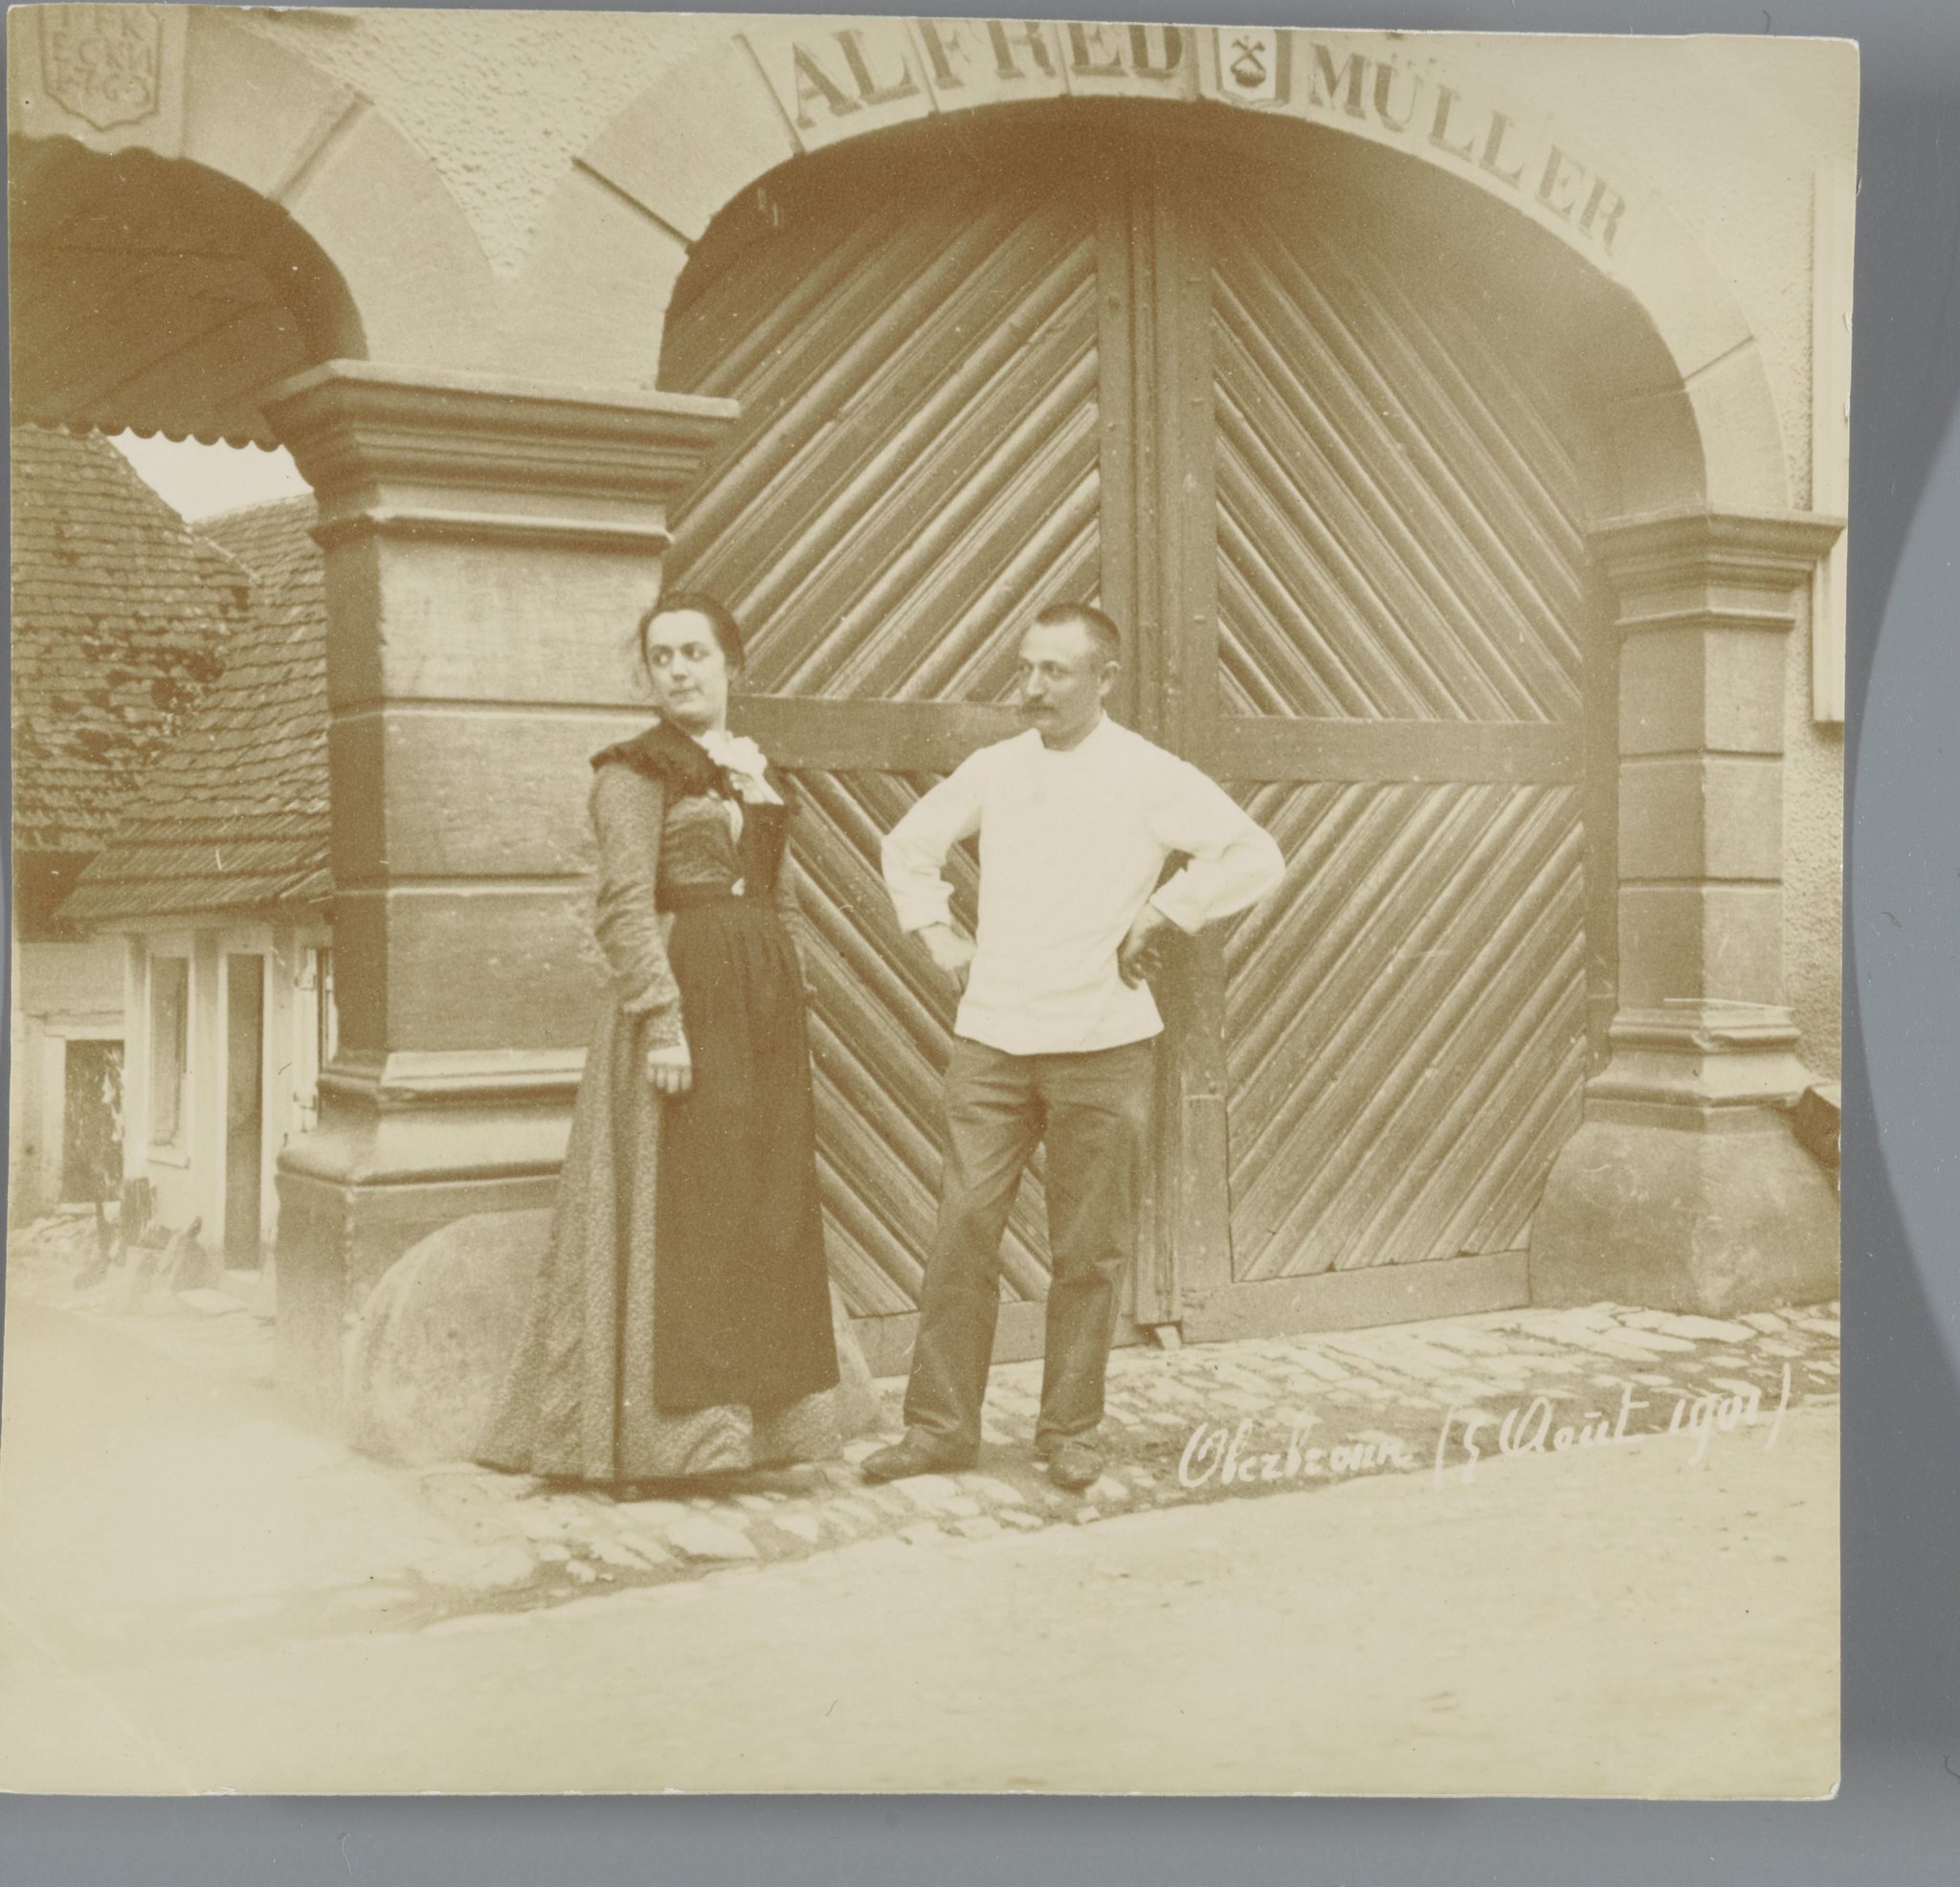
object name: photograph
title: Man en vrouw staand voor hun huis, Oberbronn (Bas-Rhin, Elzas), Frankrijk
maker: Anonymous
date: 1901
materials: paper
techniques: gelatin silver print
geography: france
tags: urban housing, france, alsace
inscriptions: annotation: ‘Oberbronn (5 Août 1901)’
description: Man en vrouw staand voor hun huis, Oberbronn (Bas-Rhin, Elzas), Frankrijk.